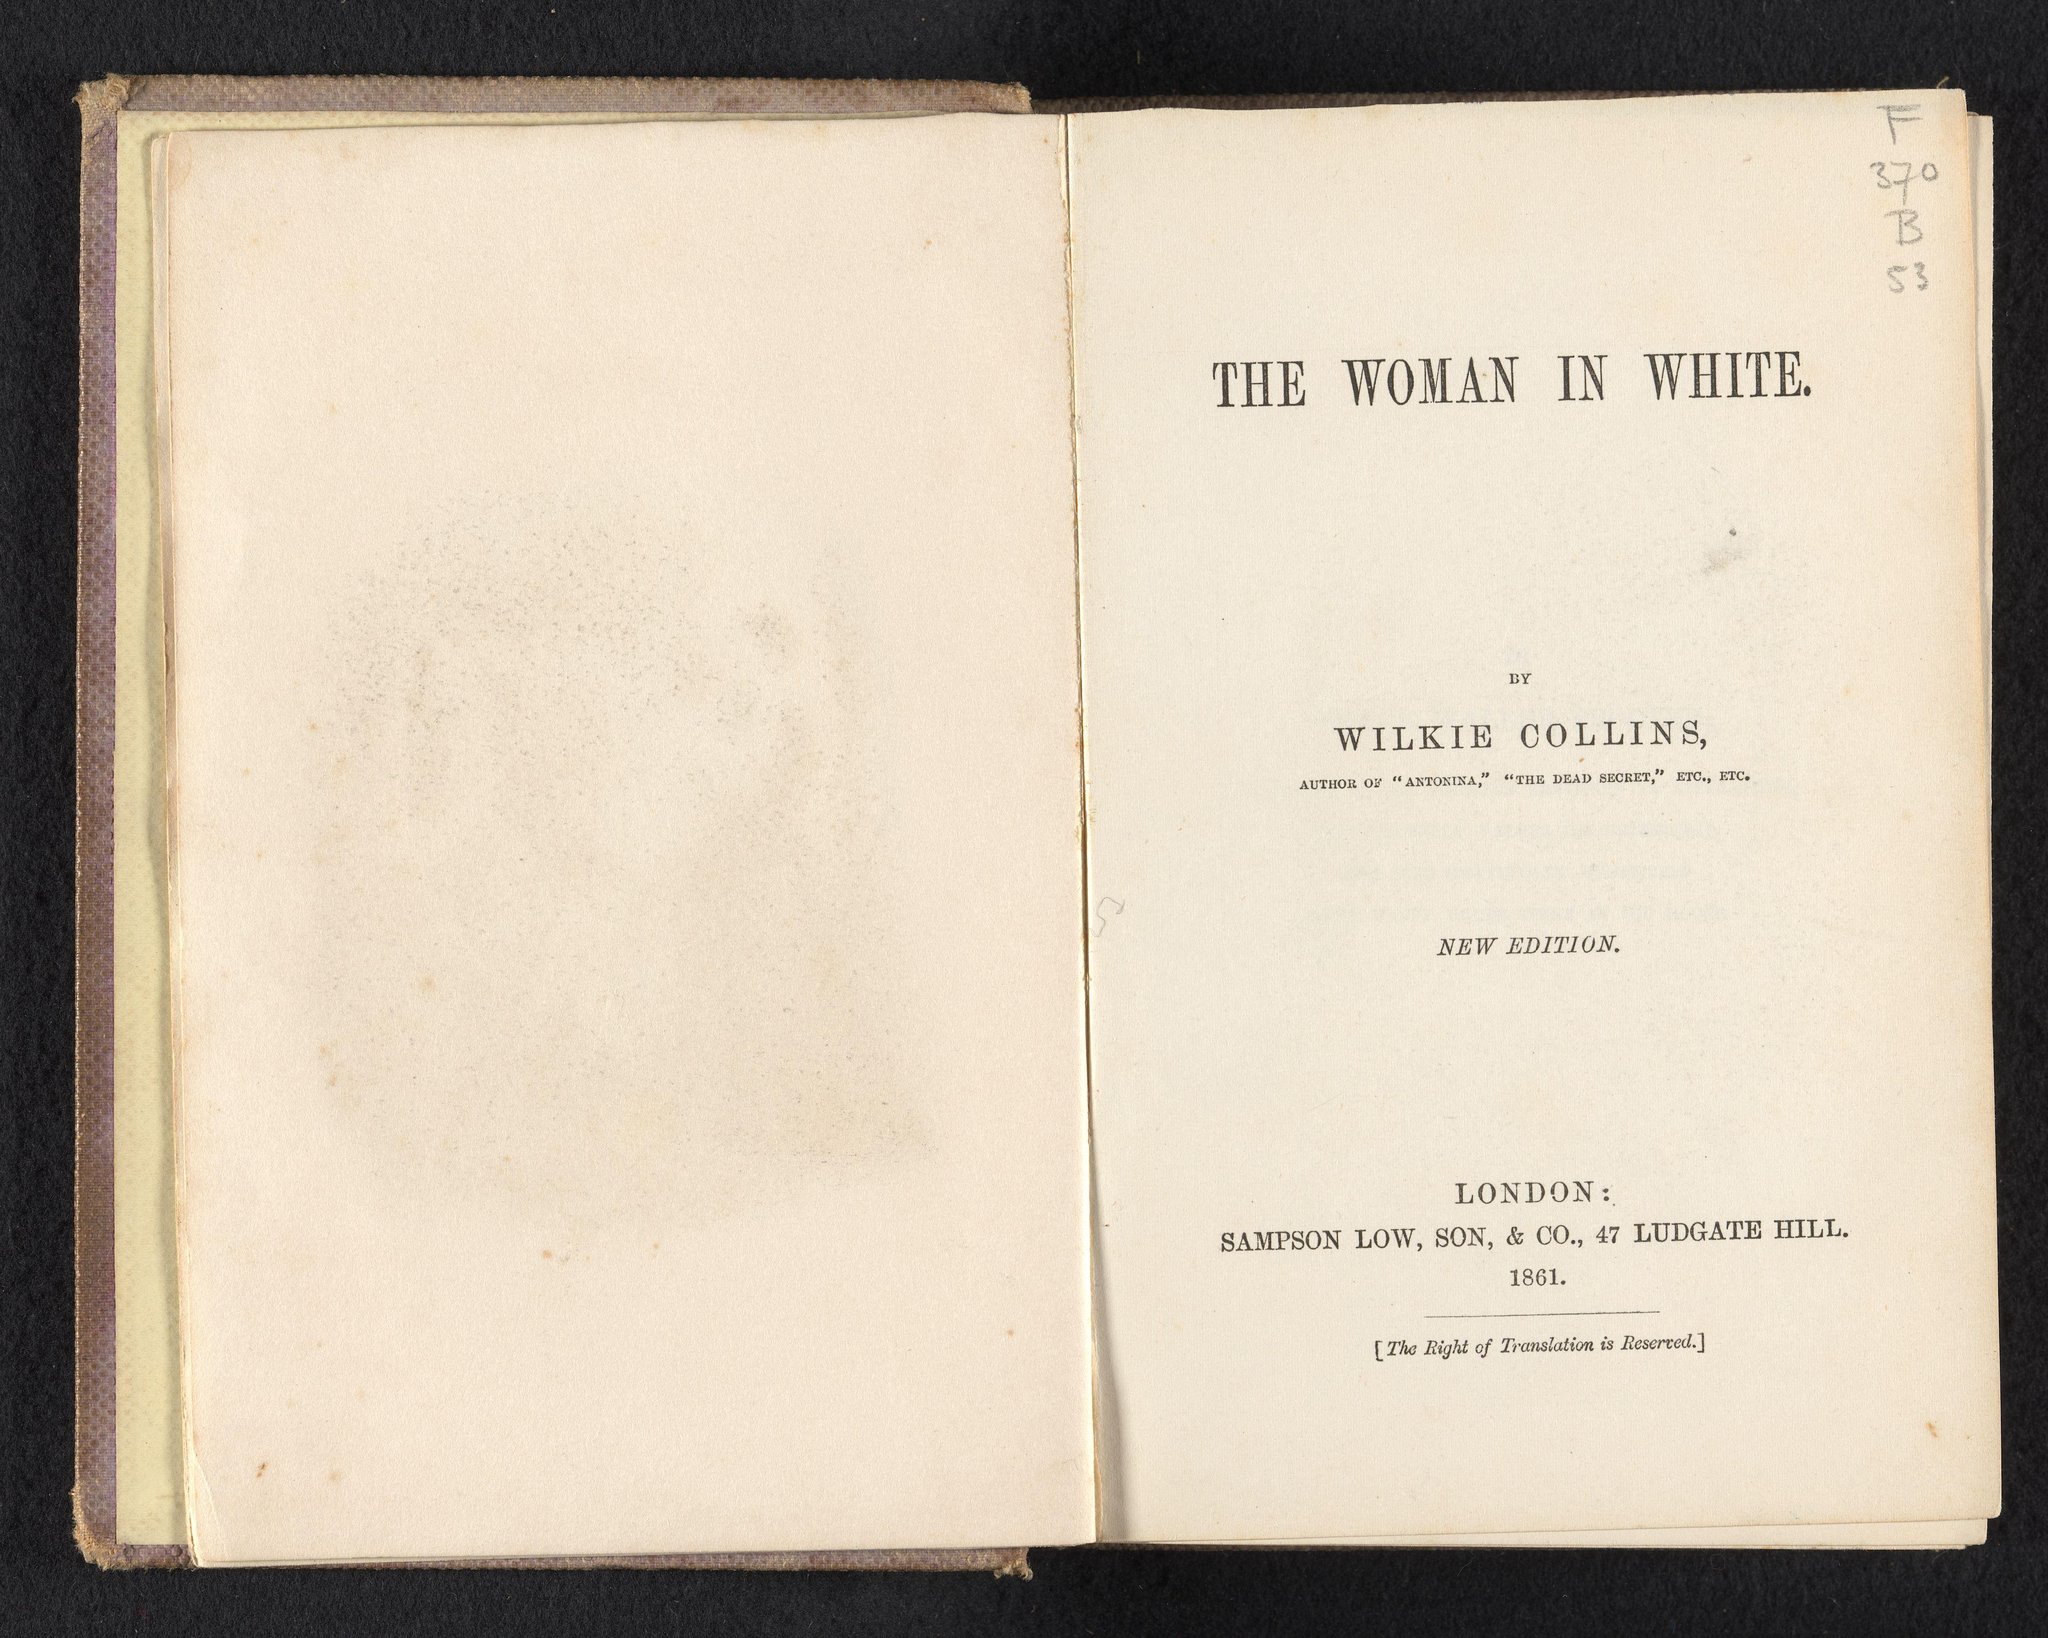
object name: book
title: The Woman in White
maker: wilkie collins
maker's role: schrijver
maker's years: 1824-1889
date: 1861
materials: cardboard, linen, paper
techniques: albumen print, engraving, letterpress printing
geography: london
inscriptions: inscription: ‘Miss I. Grimond/ Carbet Castle/ Broughty Ferry’, inscription: ‘David Grimond/ Broughty Ferry’, inscription: ‘AUG/ 2014’, inscription: ‘DGrimond/ from/ M.d.M.’